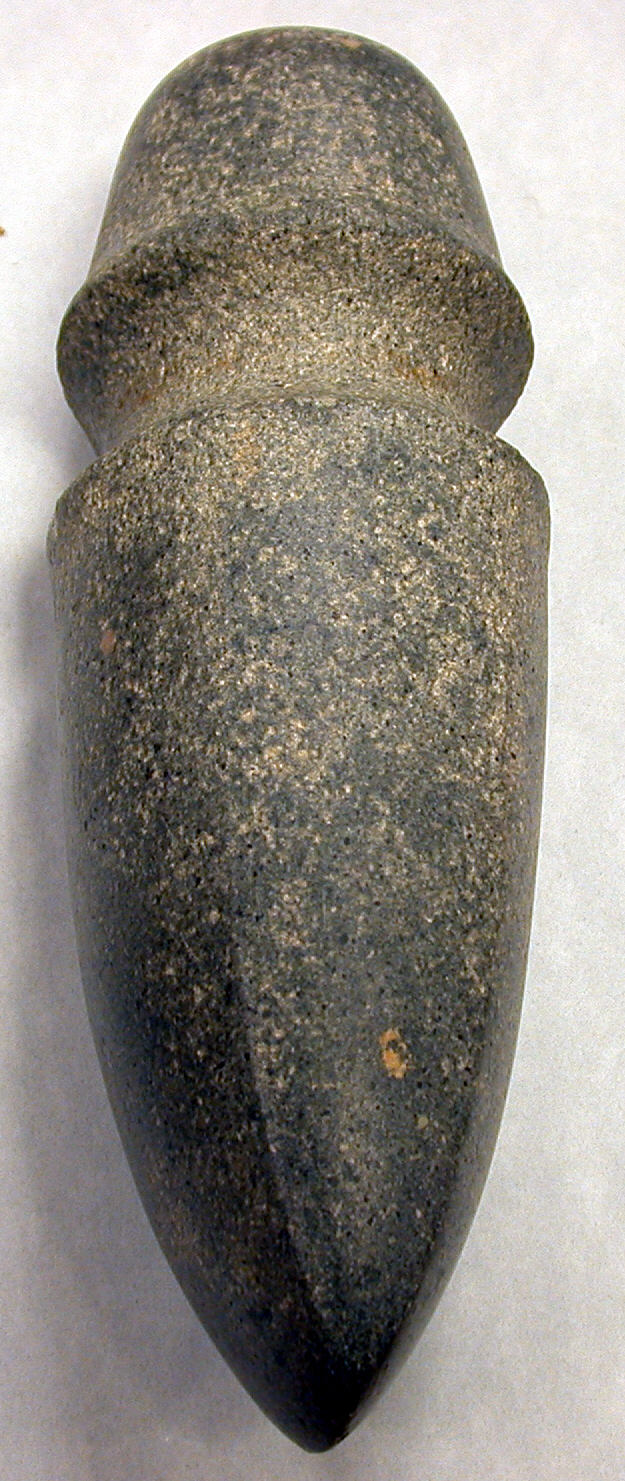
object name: knife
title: Pointed and Grooved Stone Blade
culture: woodland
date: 1501-1600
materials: stone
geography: united states